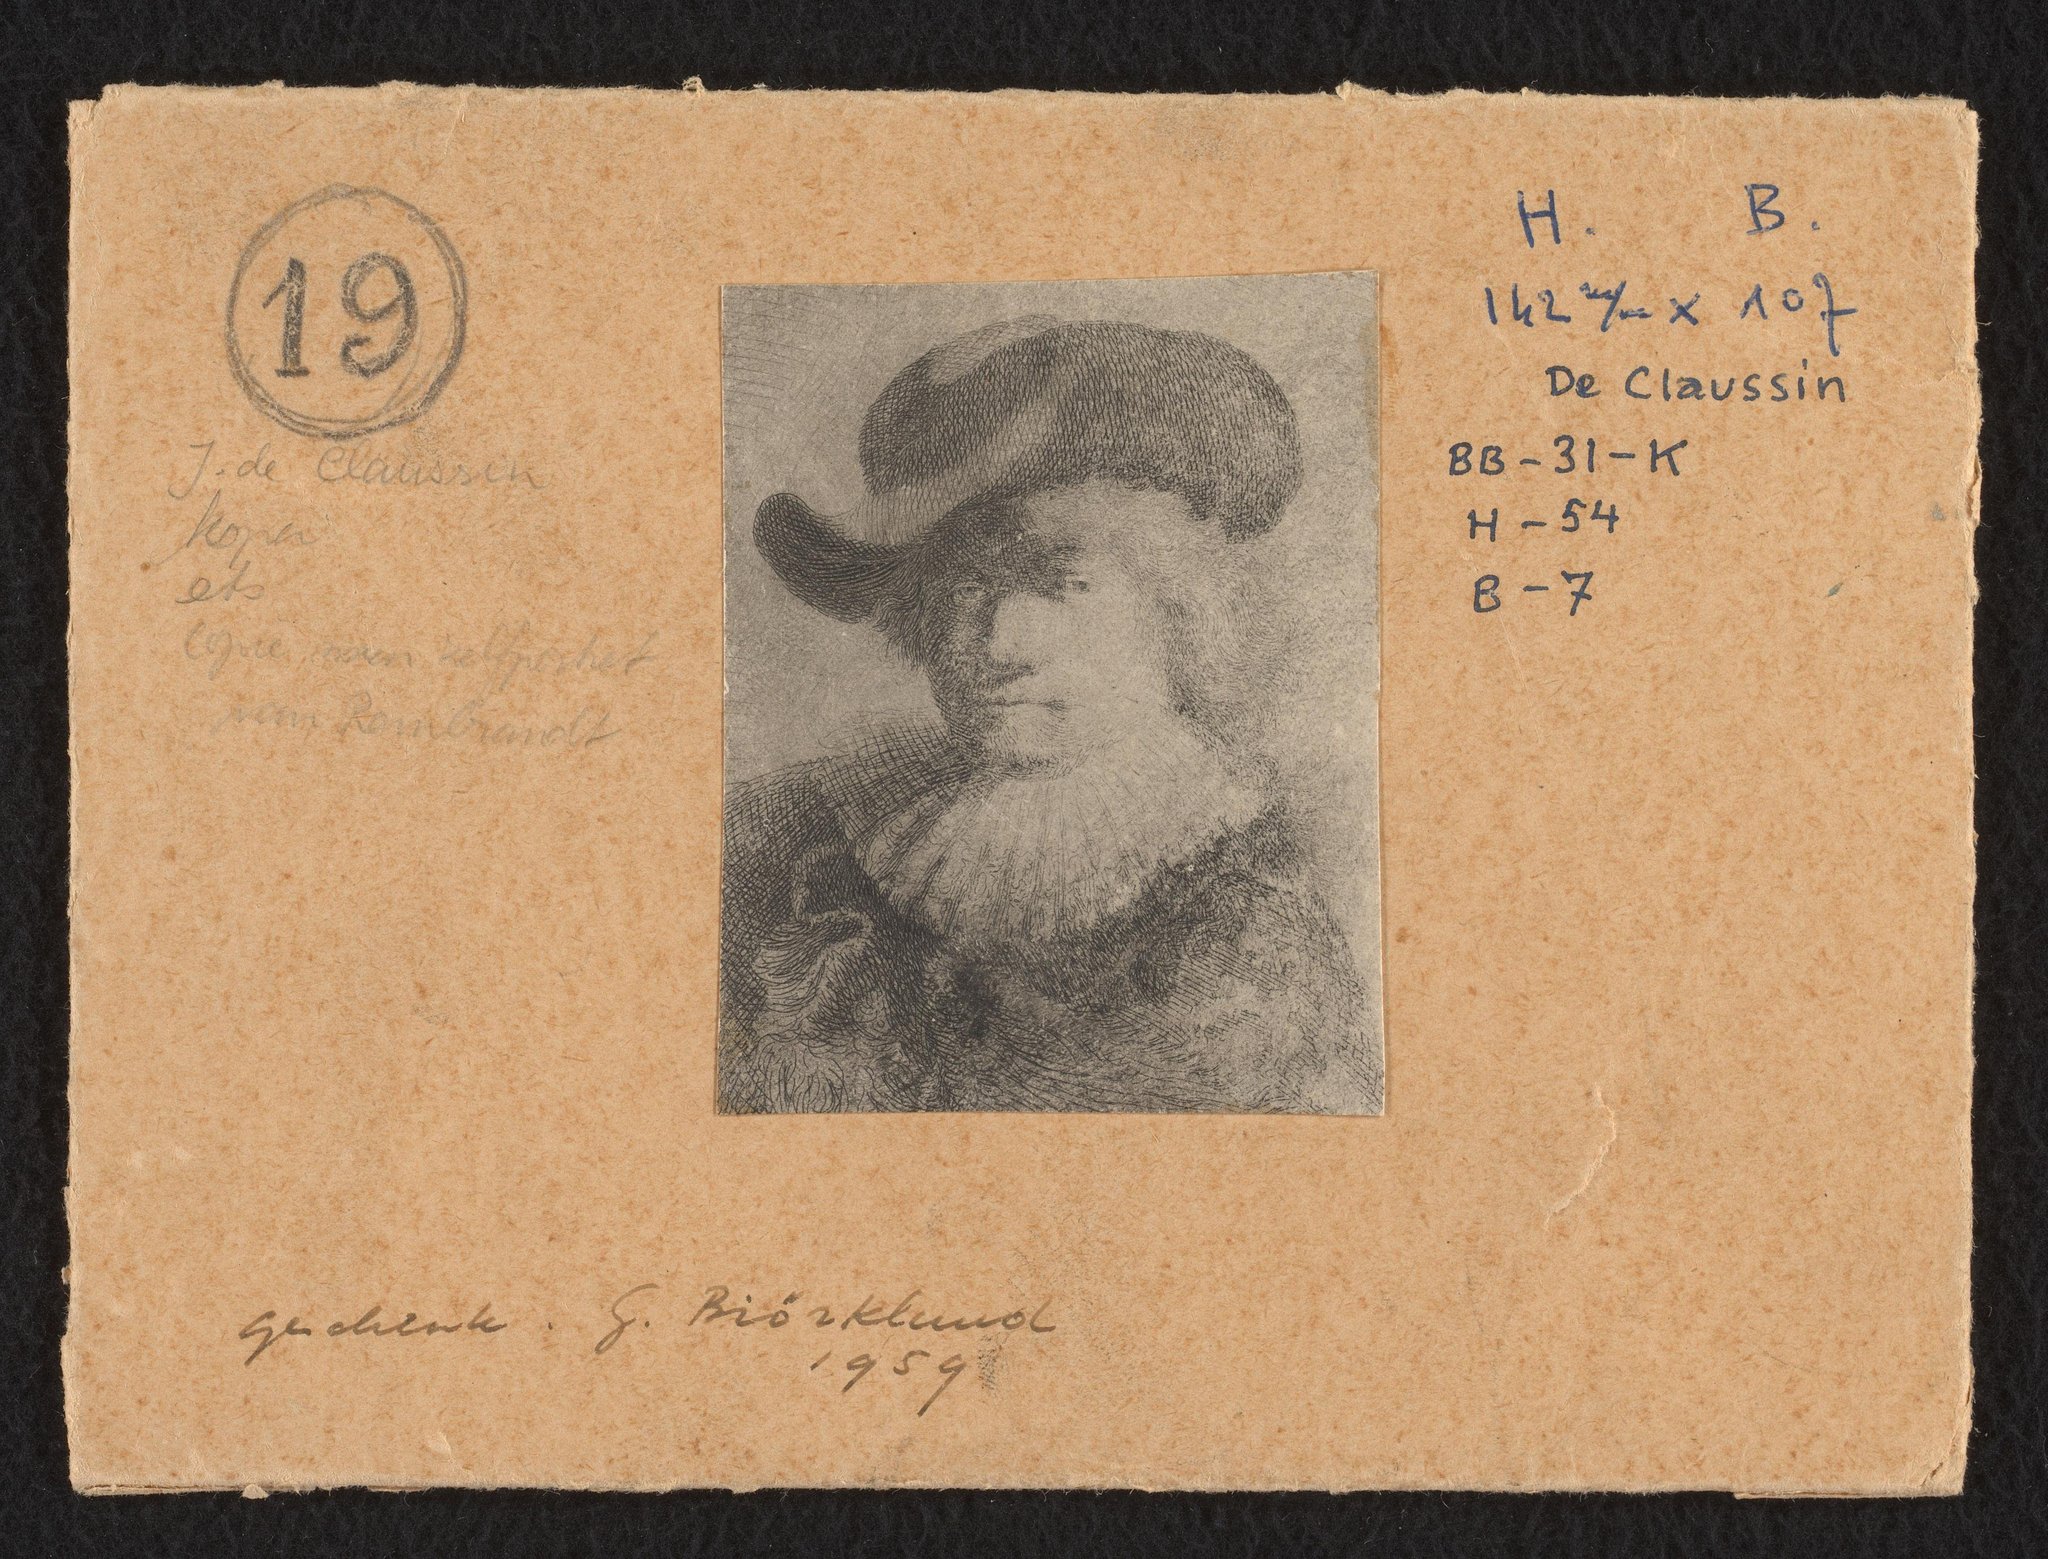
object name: print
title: Portret van Rembrandt met hoed met slappe rand en geborduurde mantel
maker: ignace-joseph de claussin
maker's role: print maker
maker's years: 1766-1844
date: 1776-1844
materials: paper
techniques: etching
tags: leiden, amsterdam, painter, print maker, draughtsman, rembrandt van rijn, historical persons, portrait, self-portrait of artist